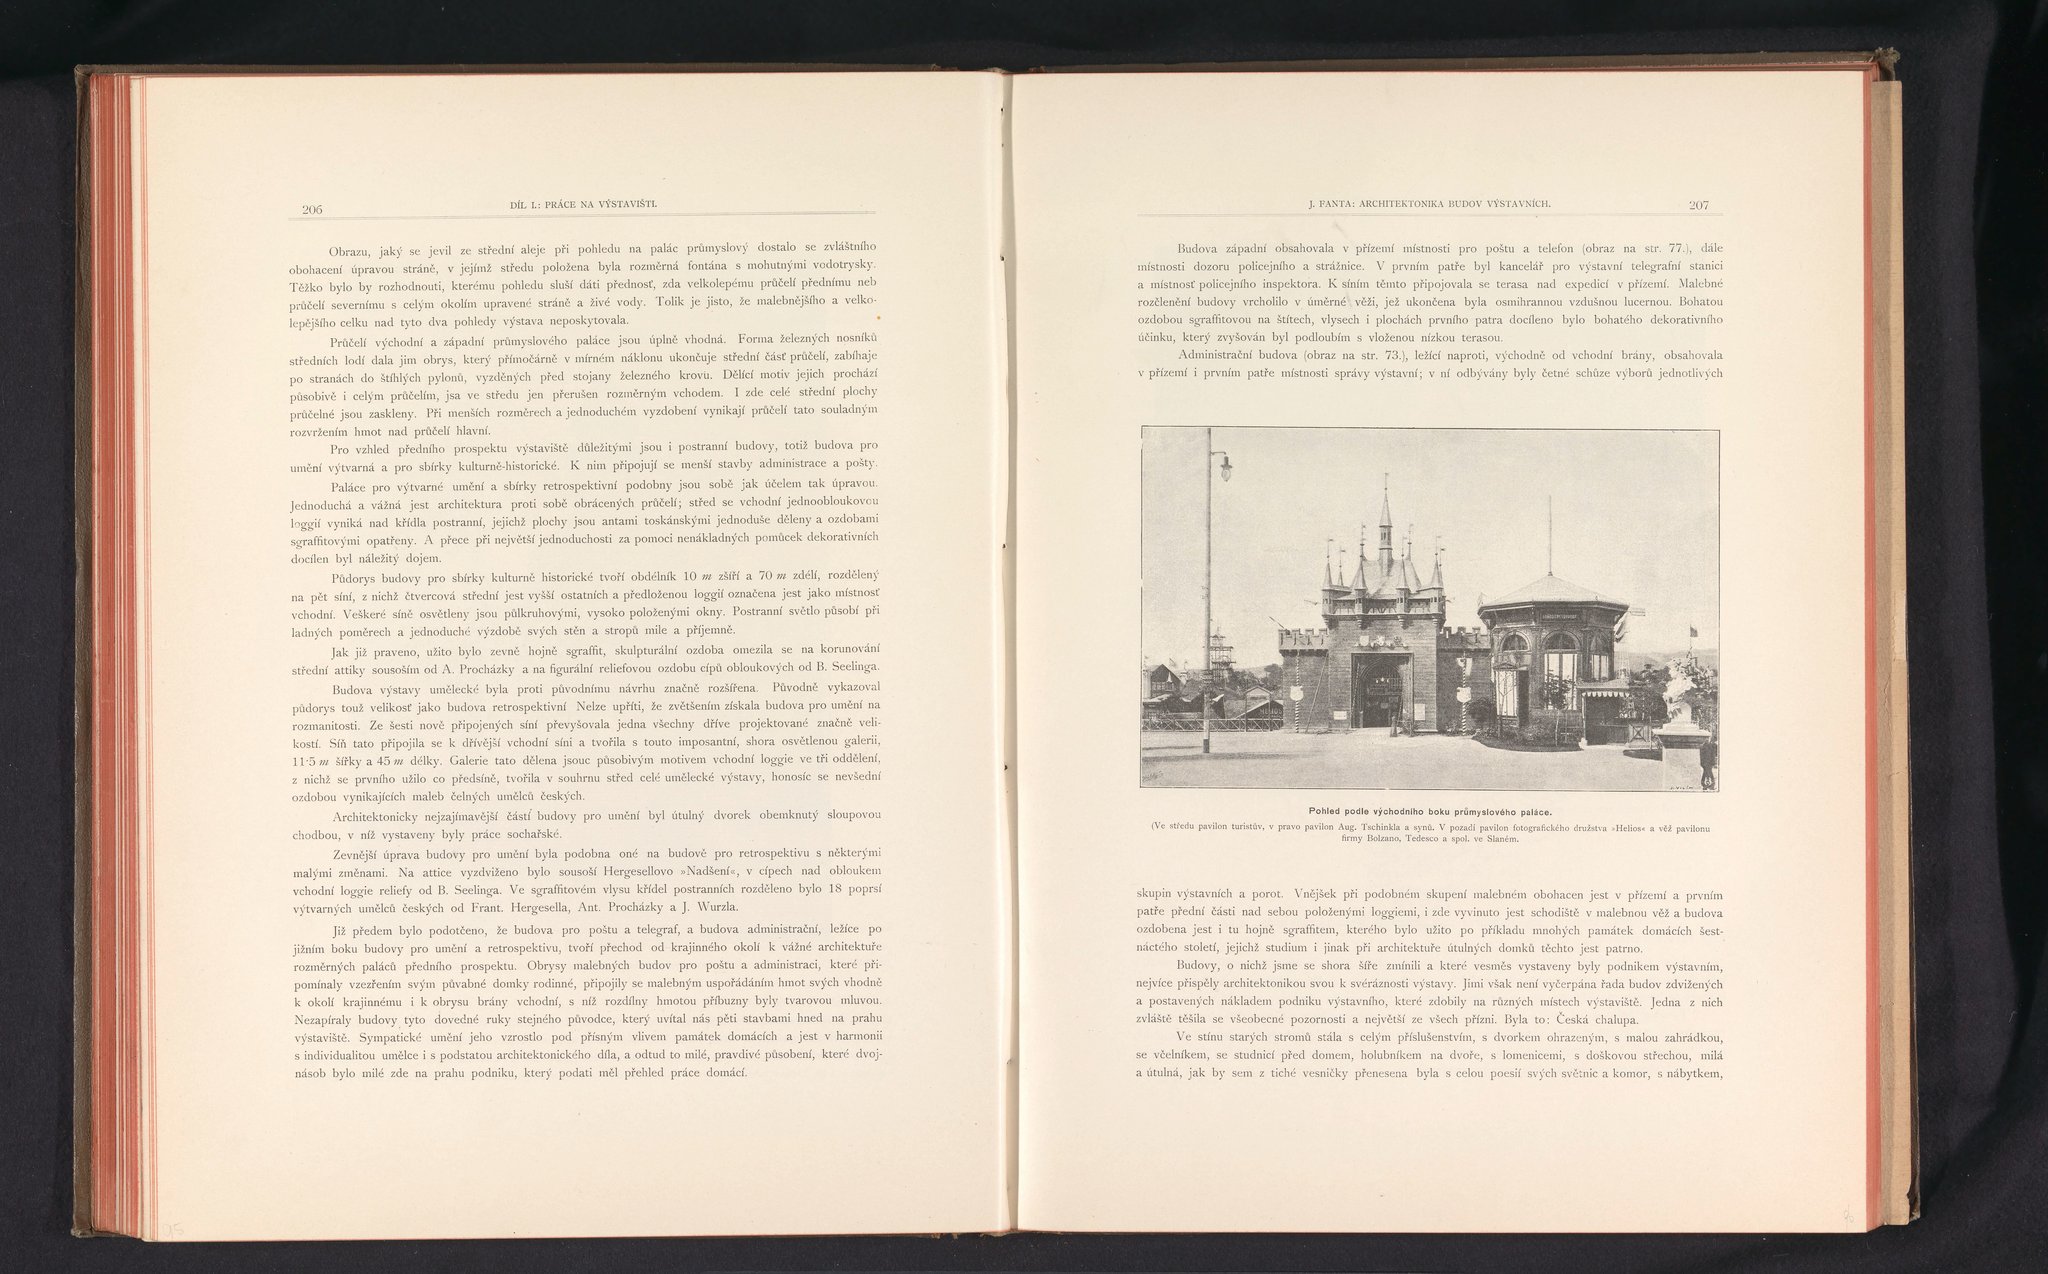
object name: page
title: Pohled podle východniho boku prumyslového paláce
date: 1891-1893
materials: paper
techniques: autotype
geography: výstaviště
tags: façade (of house or building), temporary exhibition, 'salon'